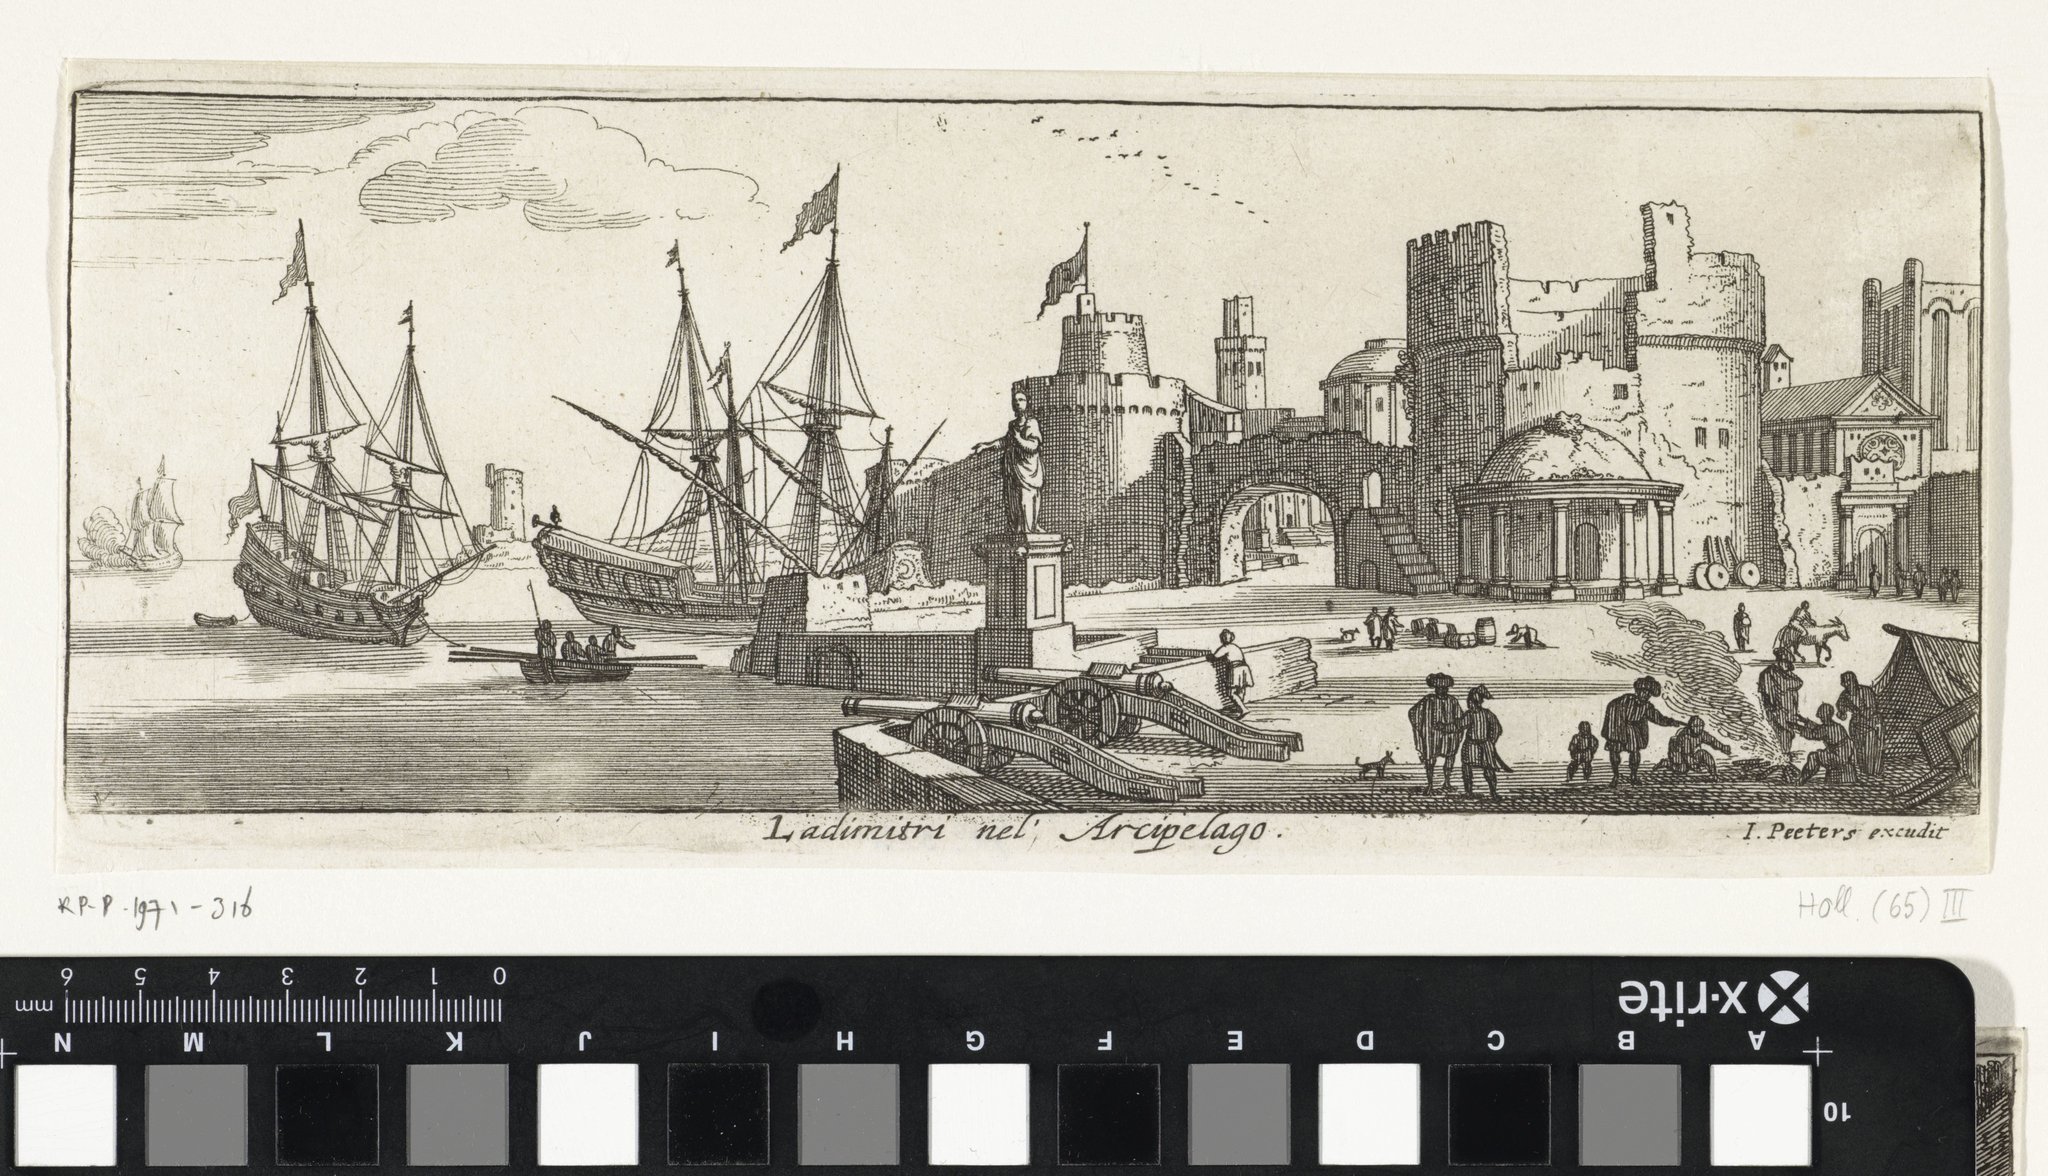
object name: print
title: Ladimitri nel Arcipelago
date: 1683-1685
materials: paper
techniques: etching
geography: antwerp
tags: harbour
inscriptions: collector's mark: Lugt 2228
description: Prent gebruikt in: Description des principales villes, havres et isles du golfe de Venise du cote oriental, comme aussi des villes et fortresses de la Moree et quelques places de la Grece et es isles principales de l'Archipel et fortresses dícelles et en suittes quelques places renommées de la Terre Saincte, et autres dessous la domination Ottomane vers le Midij et l'Orient, et quelques principales villes en Perse et le regne du Grand Mogol le tout en Abrege. Antwerpen: Jacob Peeters, s.a.